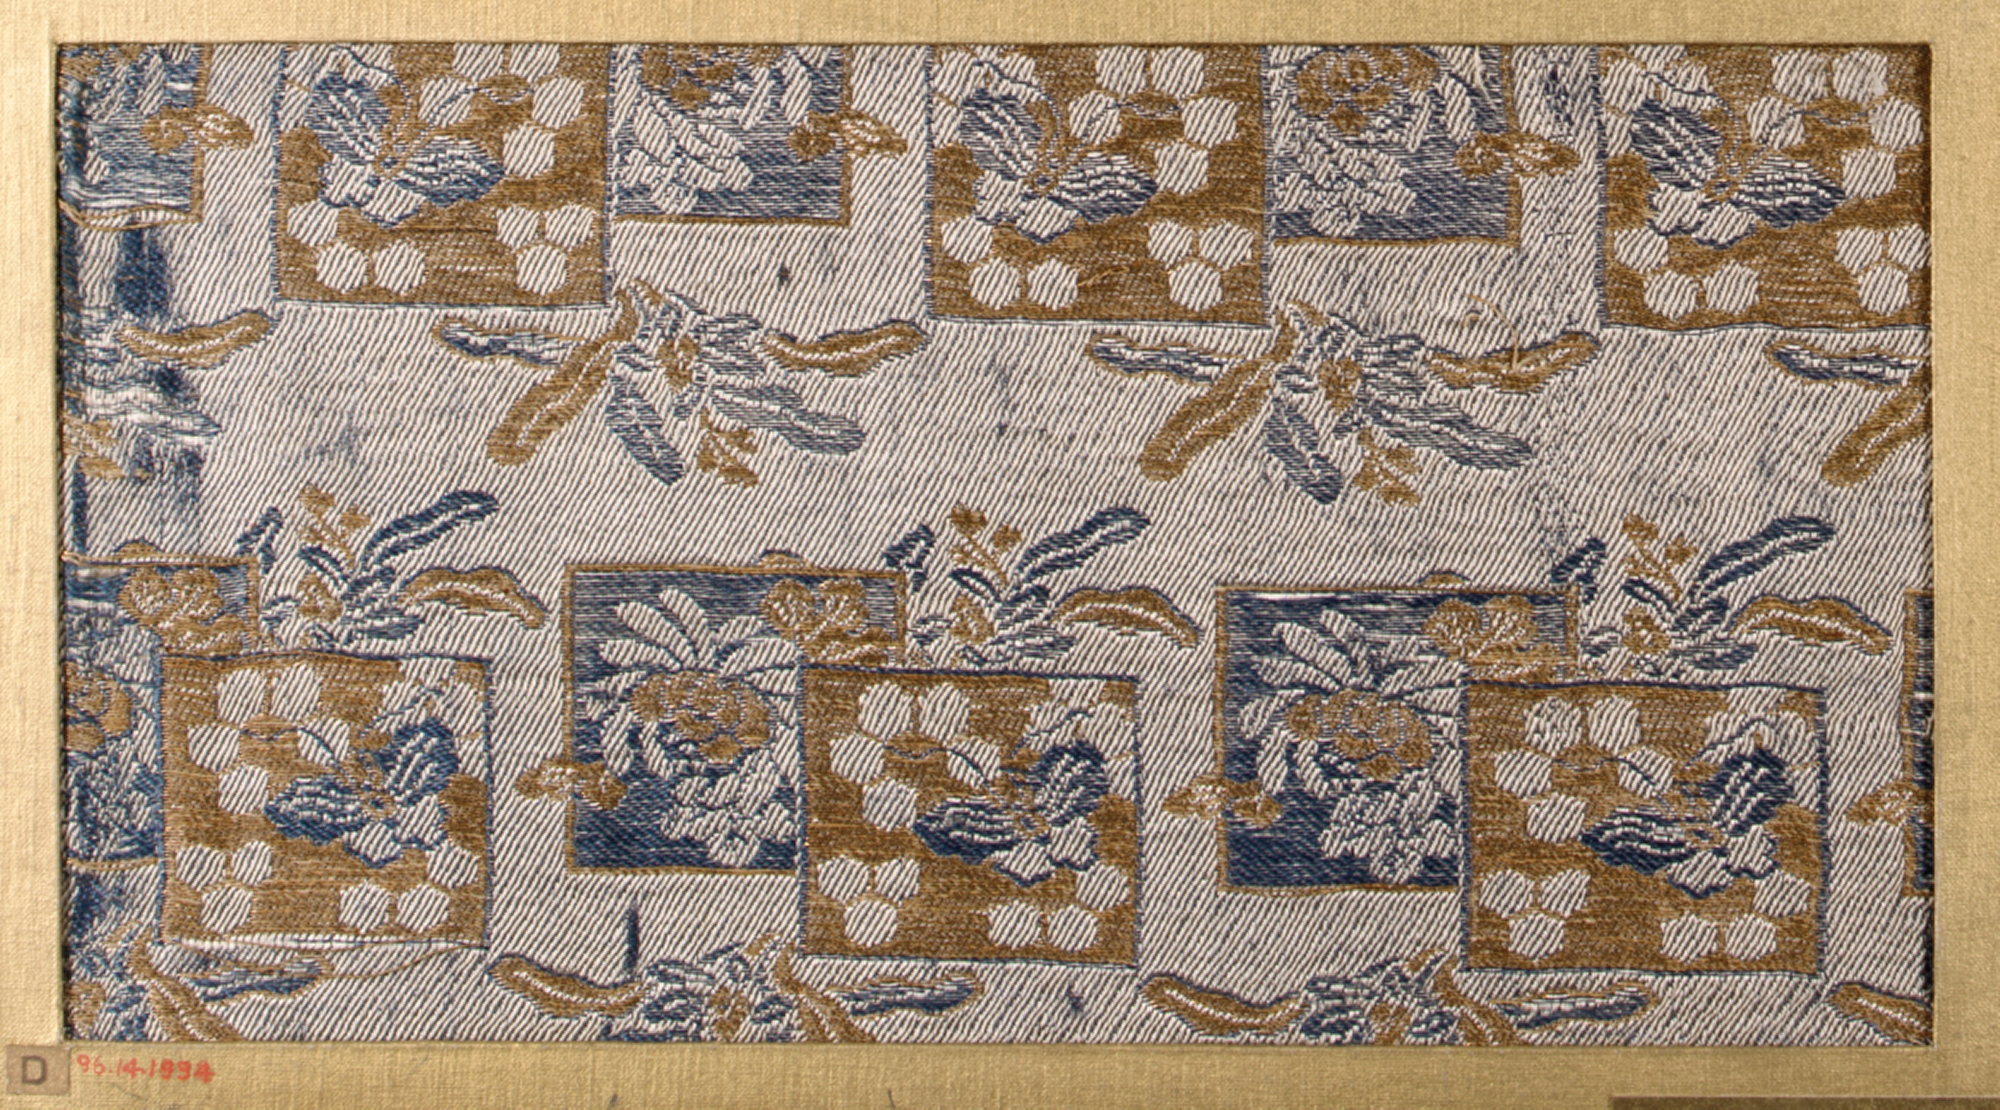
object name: piece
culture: japanese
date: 1701-1900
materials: silk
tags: butterflies